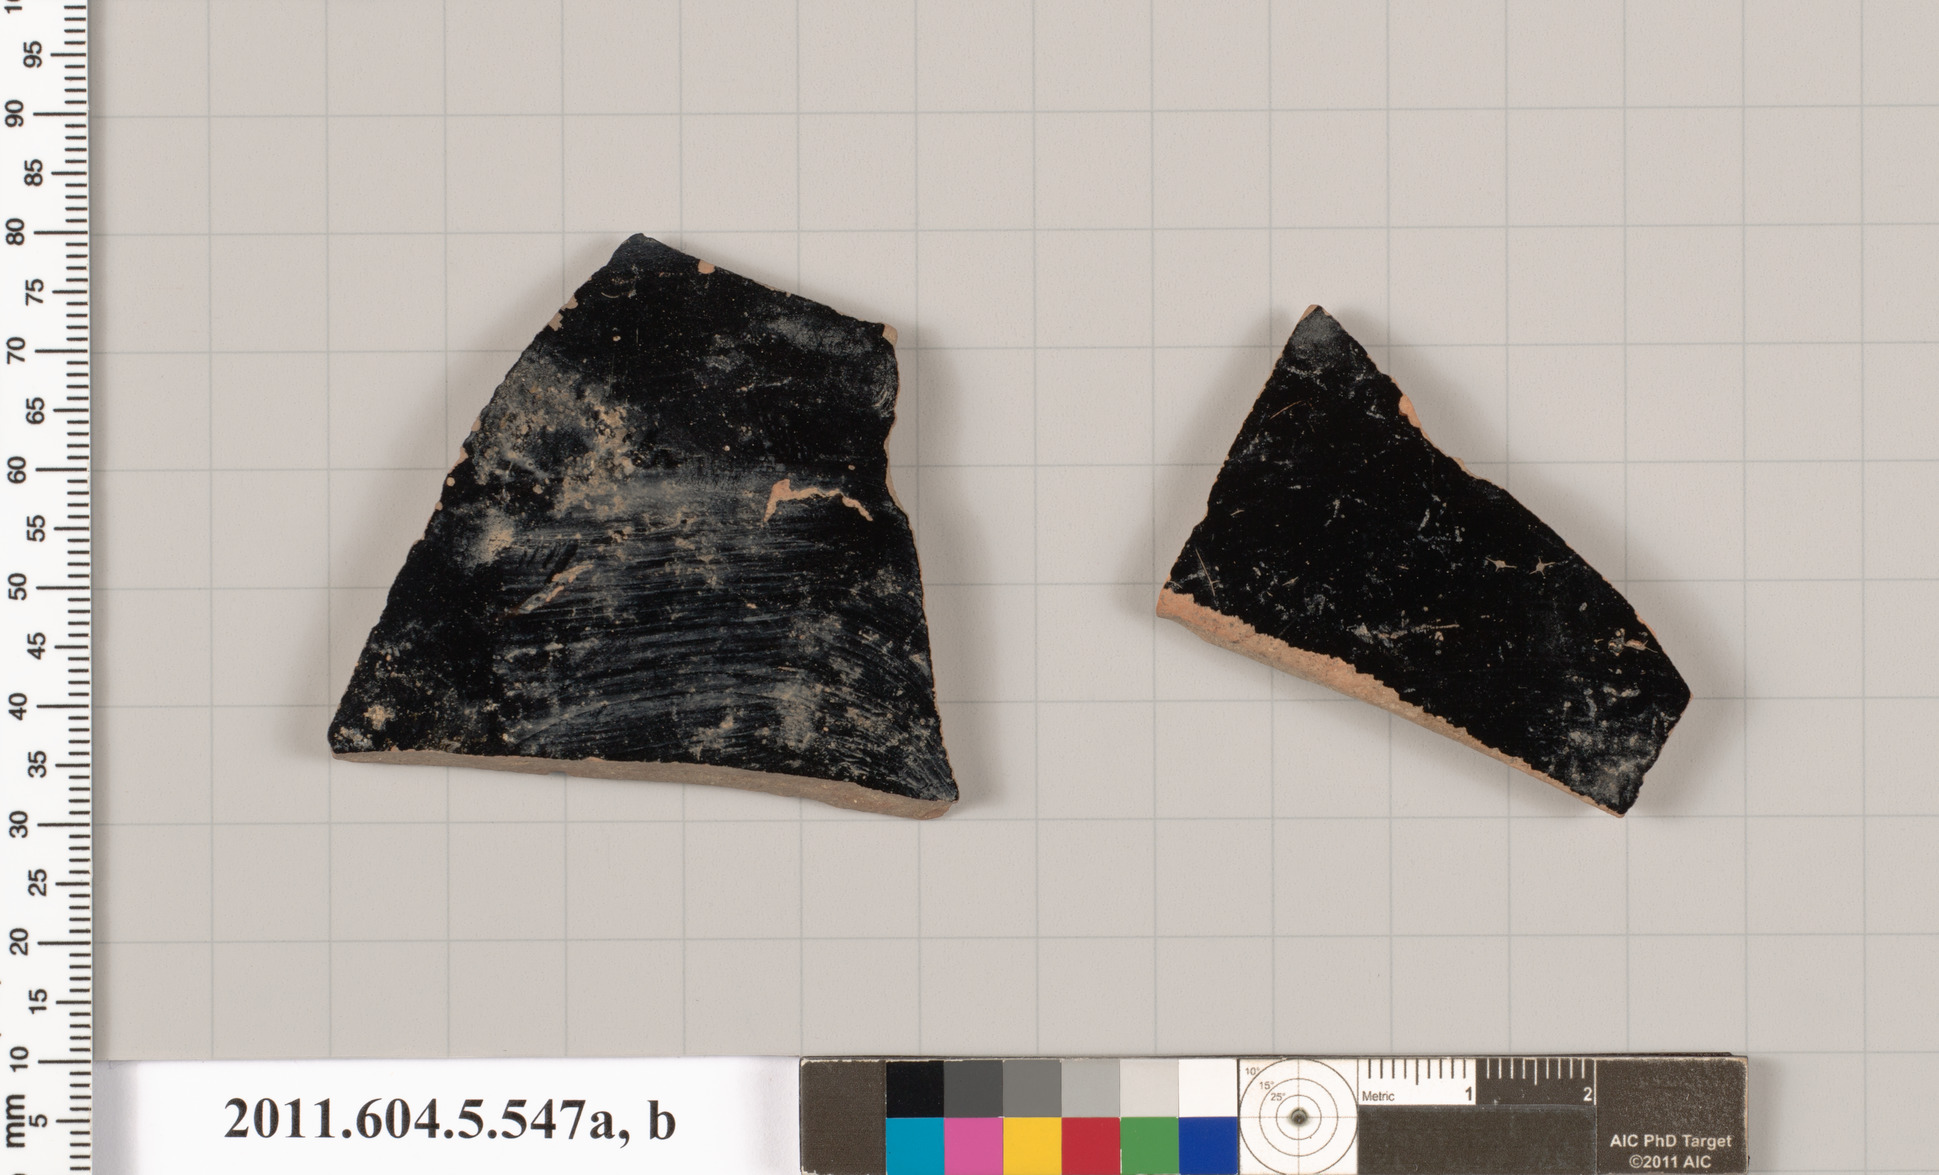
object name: kylix fragment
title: Terracotta fragments of a kylix (drinking cup)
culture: greek, attic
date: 600-401 BCE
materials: terracotta